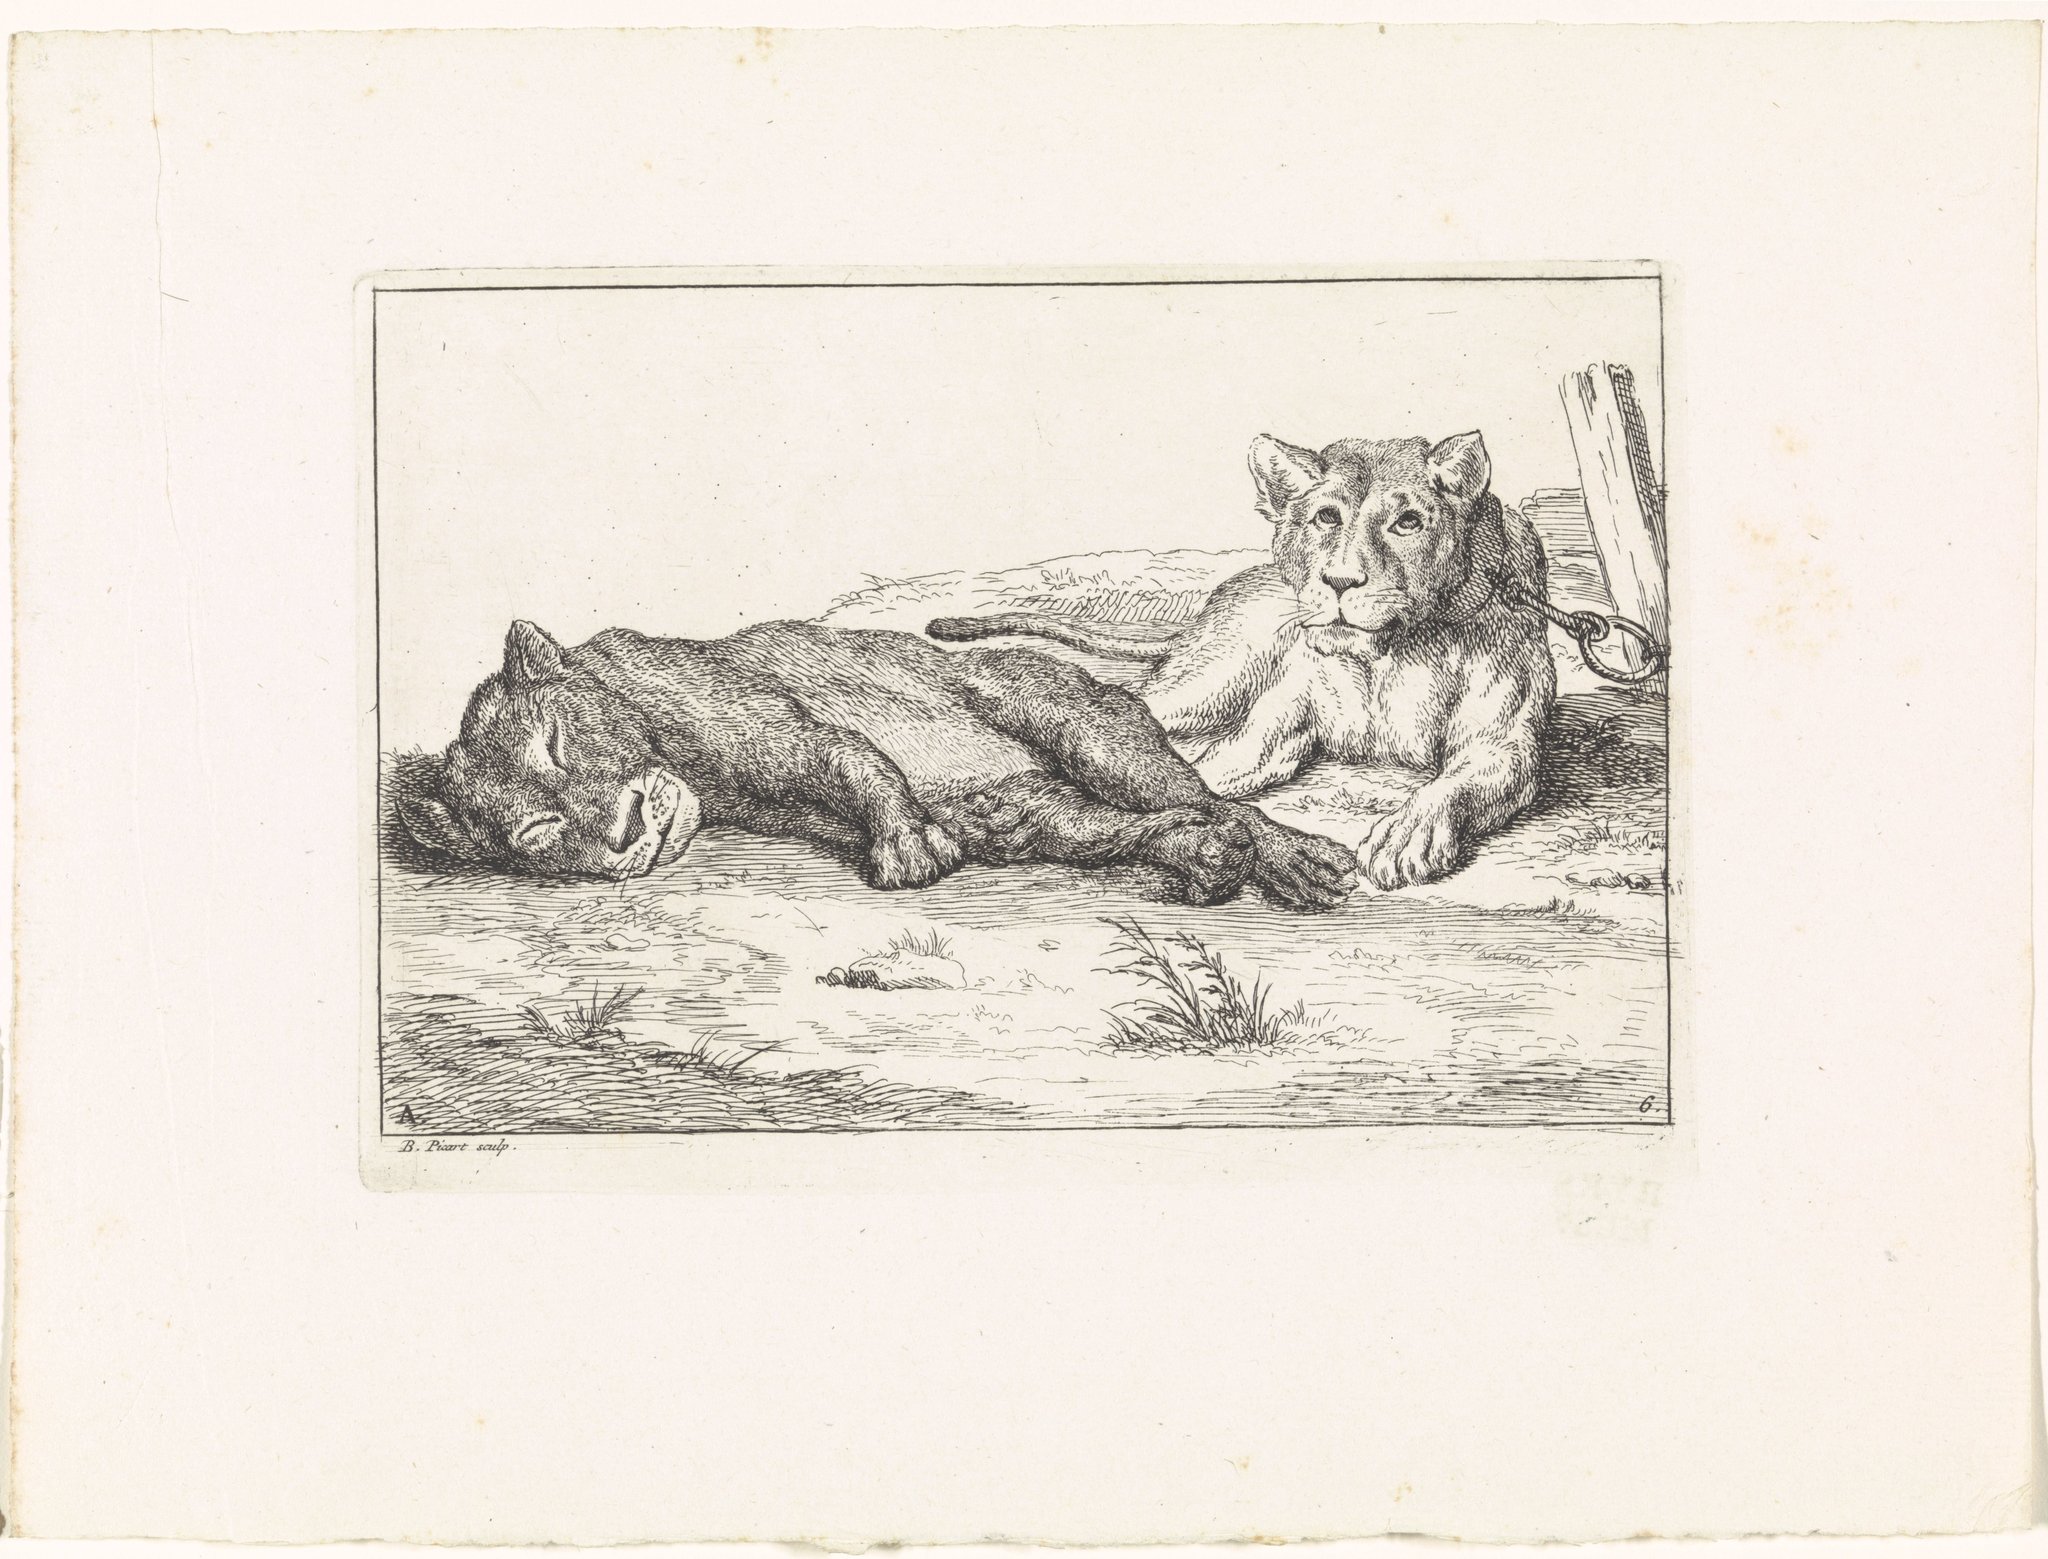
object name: print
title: Twee liggende leeuwen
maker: bernard picart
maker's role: draughtsman, print maker, publisher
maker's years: 1673-1733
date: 1729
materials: paper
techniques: etching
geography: amsterdam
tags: beasts of prey, predatory animals: lion, tools, aids, implements ~ crafts and industries: chain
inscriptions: collector's mark: Lugt 2165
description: Prent ook als illustratie gebruikt in: Recueil de lions, dessinez d'après nature par divers maitres. Amsterdam: Bernard Picart, 1729.